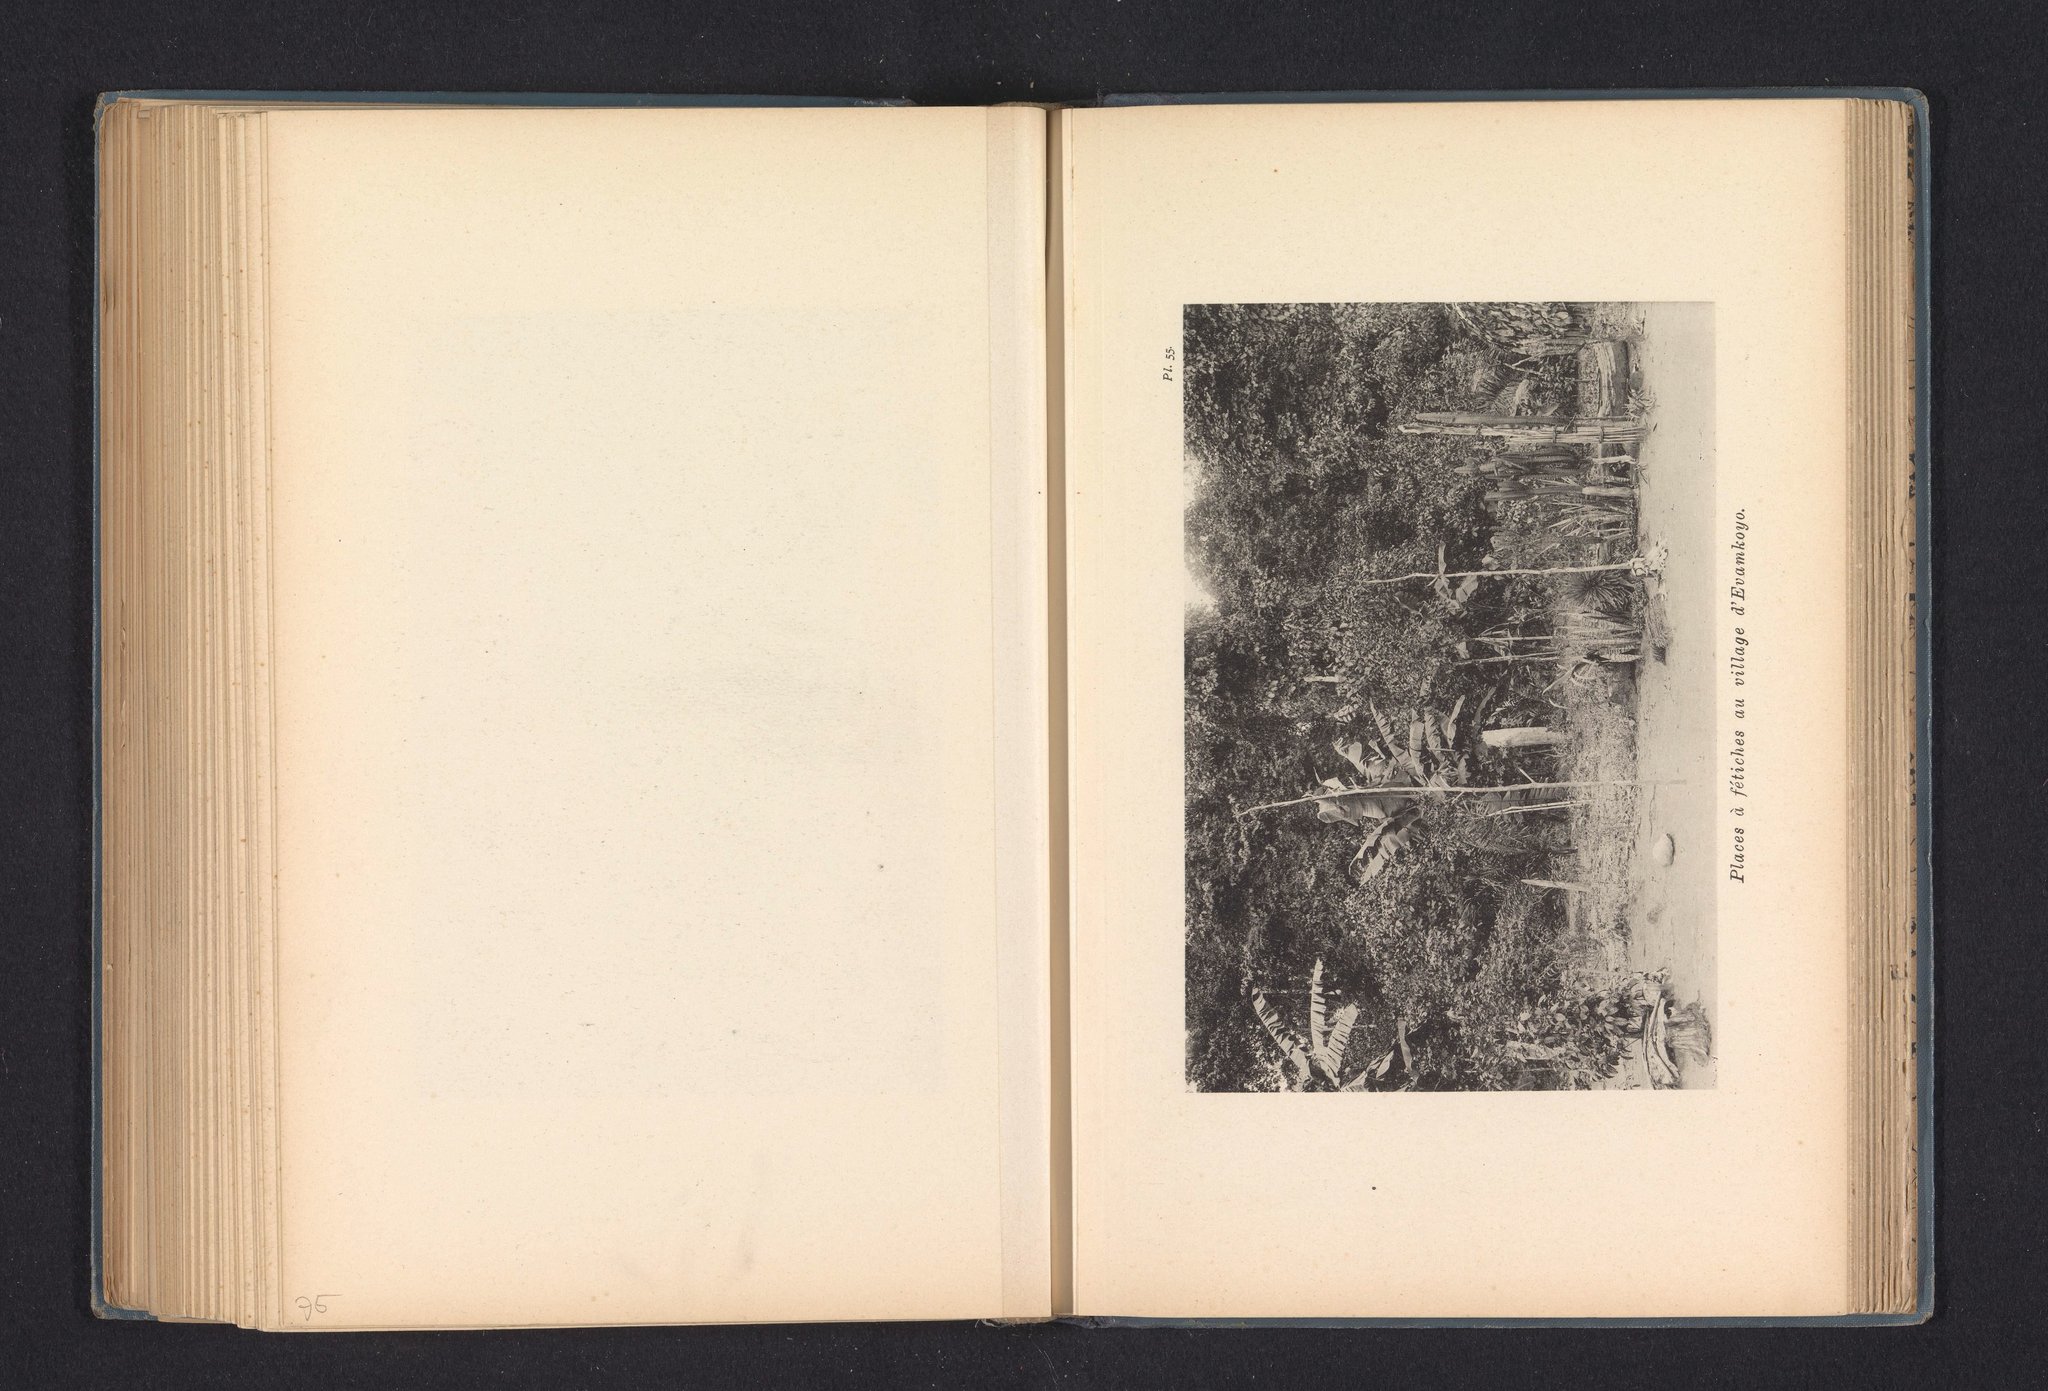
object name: page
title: Plein te Evamkoyo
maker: franz thonner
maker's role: botanicus, ontdekkingsreiziger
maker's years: 1863-1928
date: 1896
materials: paper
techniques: photograph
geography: dresden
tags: village square, place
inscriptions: number: ‘Pl. 55.’